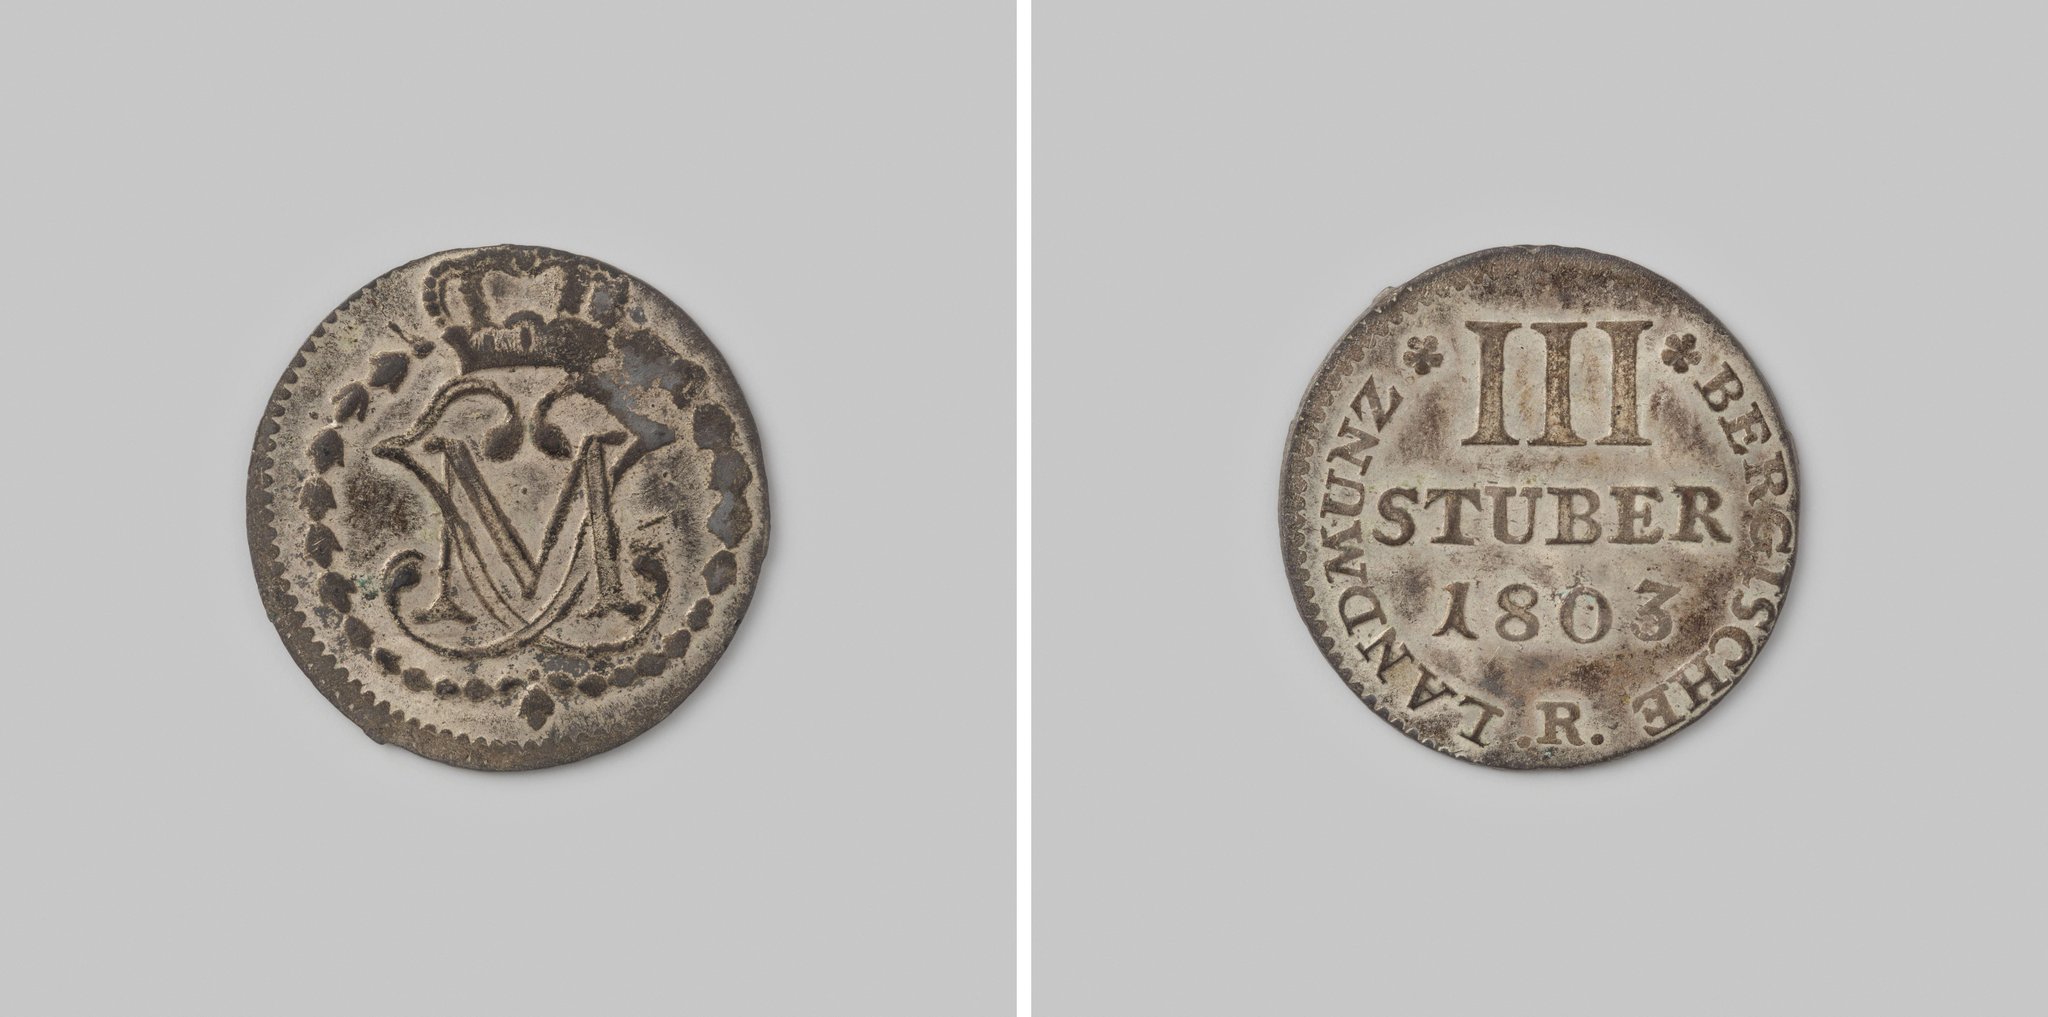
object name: coin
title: Hertogdom Berg, 3 Stuber, Maximilian Joseph, 1803 R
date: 1803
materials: silver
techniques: striking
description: Zilveren munt. Voorzijde: binnen bladerkrans gekroond monogram van de hertog. Keerzijde: waarde-aanduiding in twee regels, waaronder jaartal. Letter R onderaan in omschrift. Gladde rand.